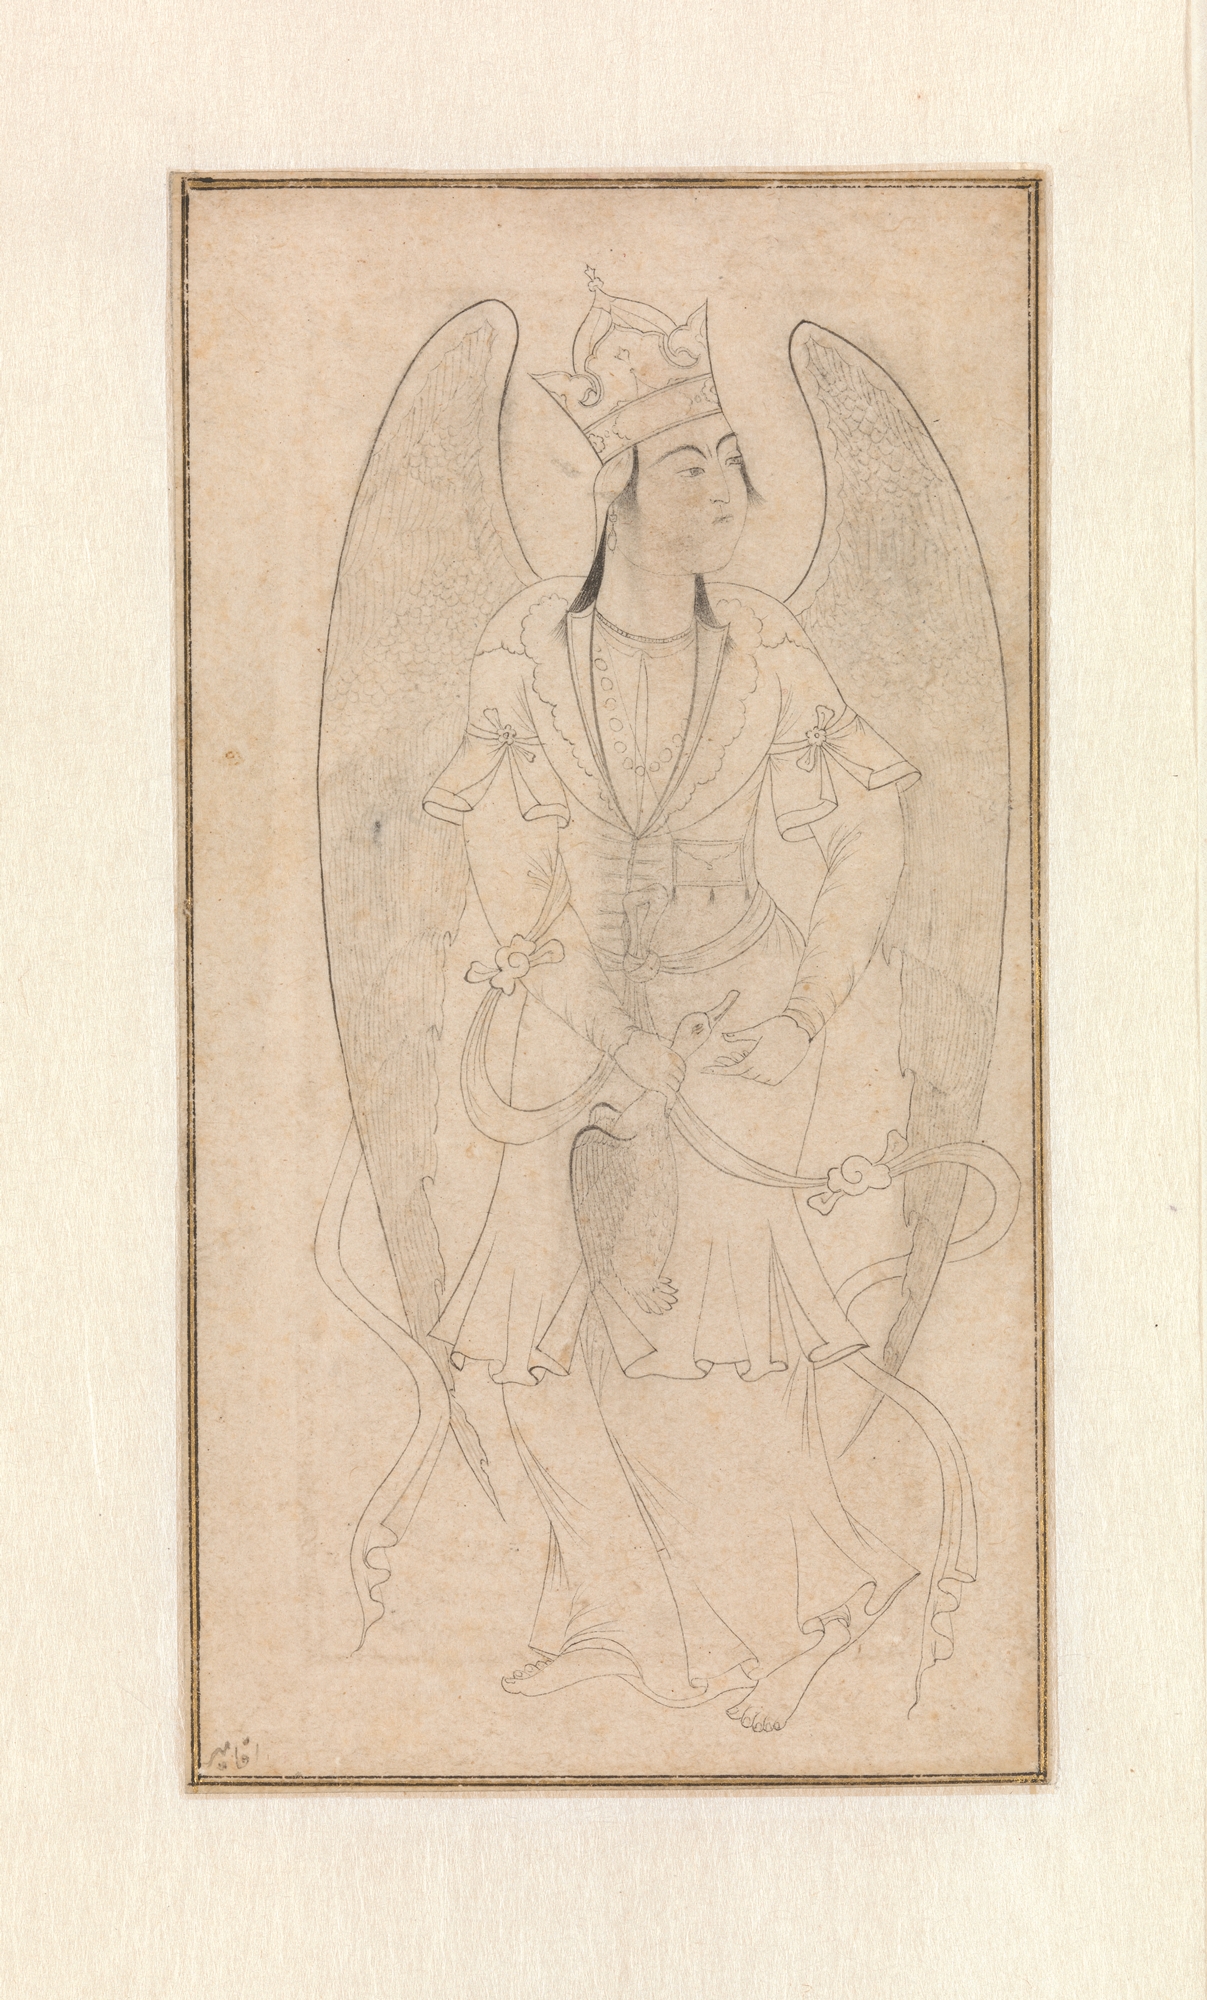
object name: illustrated single work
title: Drawing of an Angel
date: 1501-1600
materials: gold, ink, paper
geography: iran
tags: angels